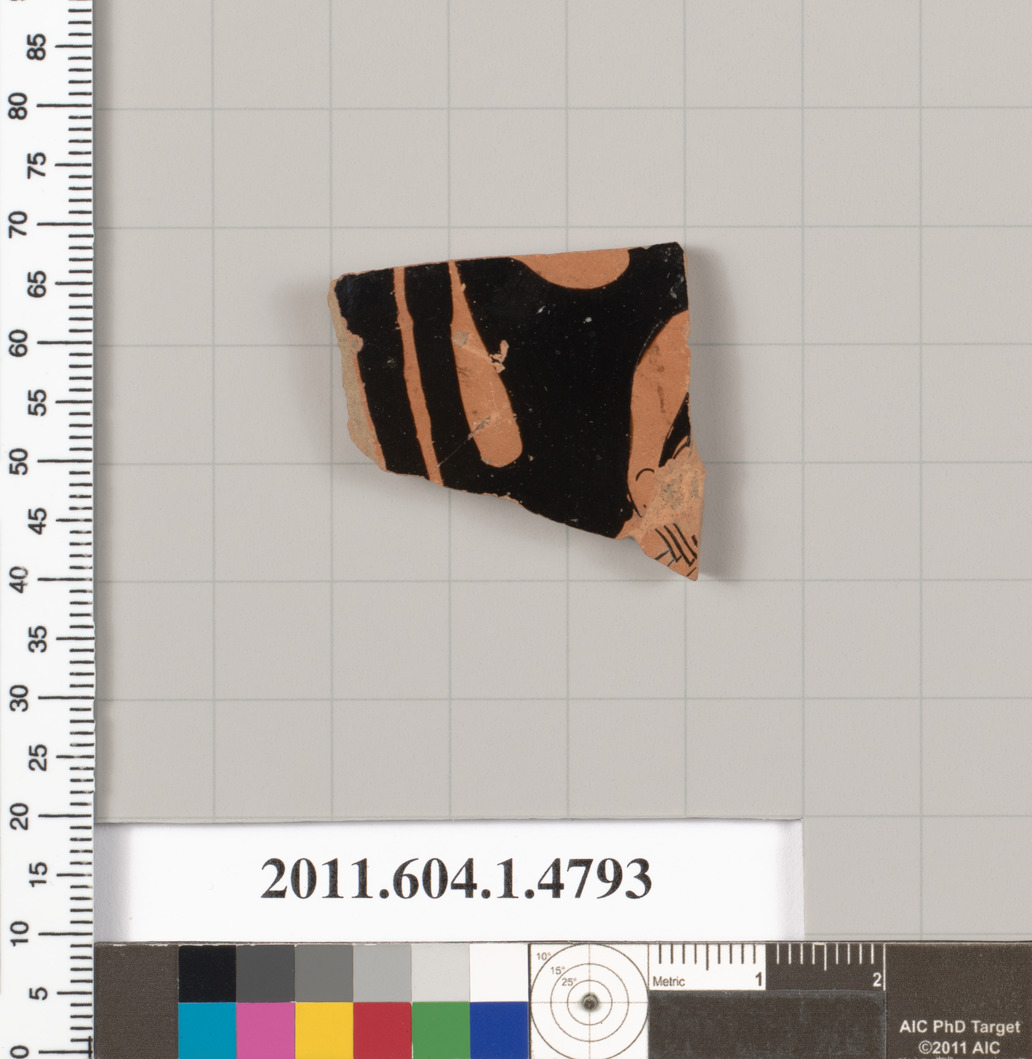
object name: kylix fragment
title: Terracotta fragment of a kylix (drinking cup)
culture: greek, attic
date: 475-451 BCE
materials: terracotta